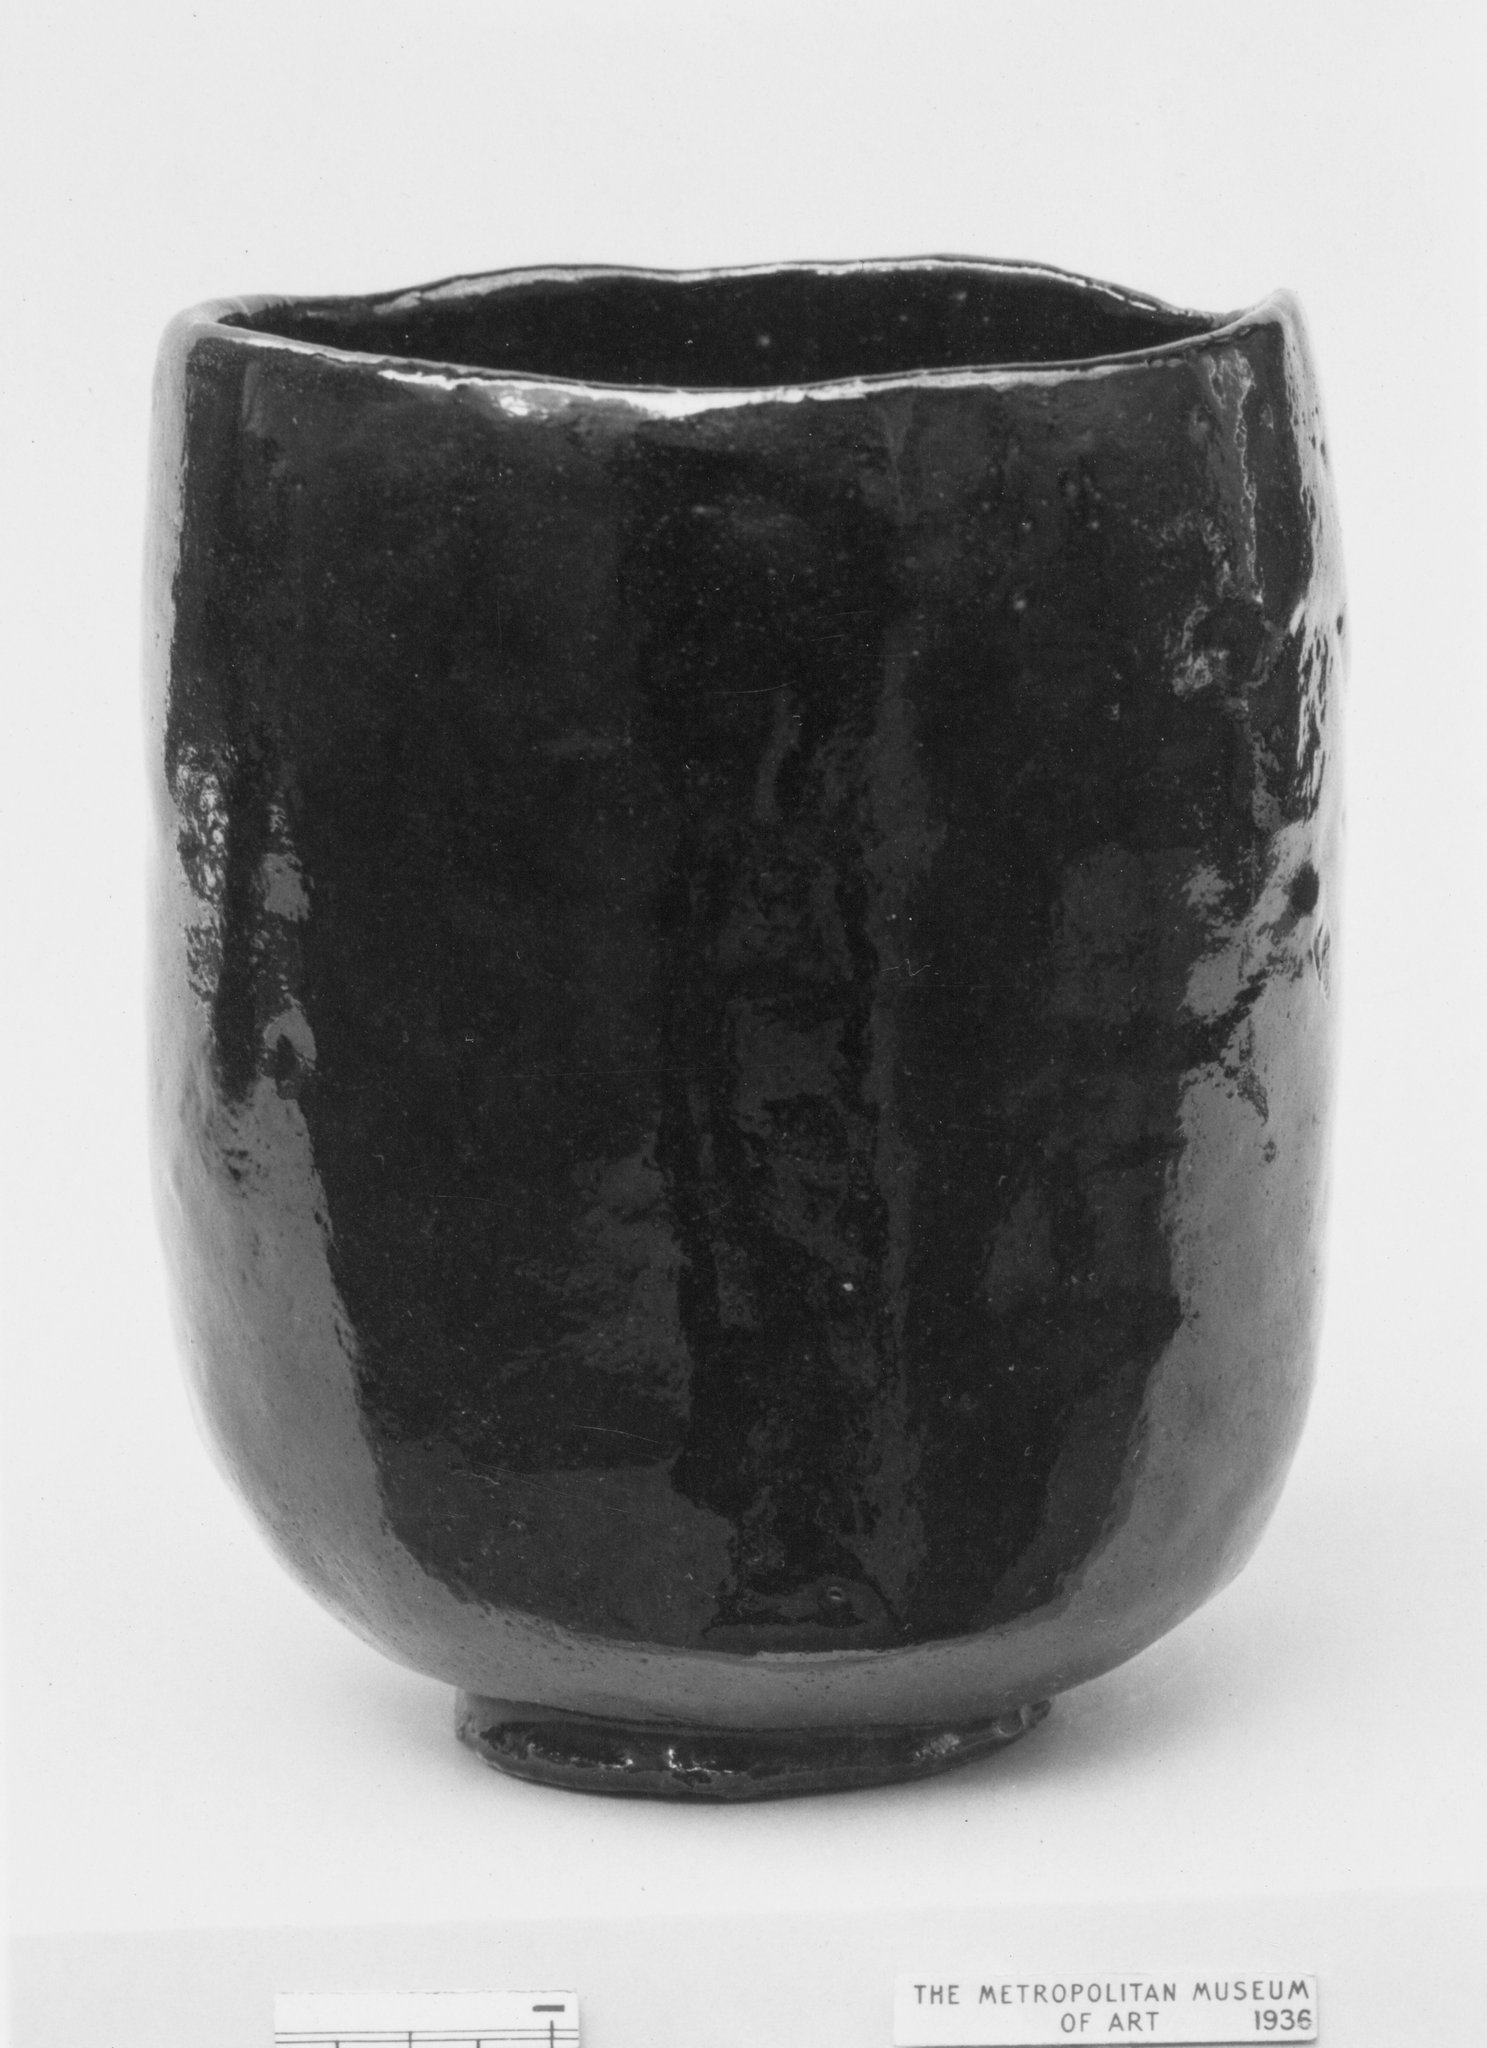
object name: teabowl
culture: japanese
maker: sonyu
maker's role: artist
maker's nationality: japanese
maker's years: 1625-1725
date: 1701-1800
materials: clay, glaze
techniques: underglaze